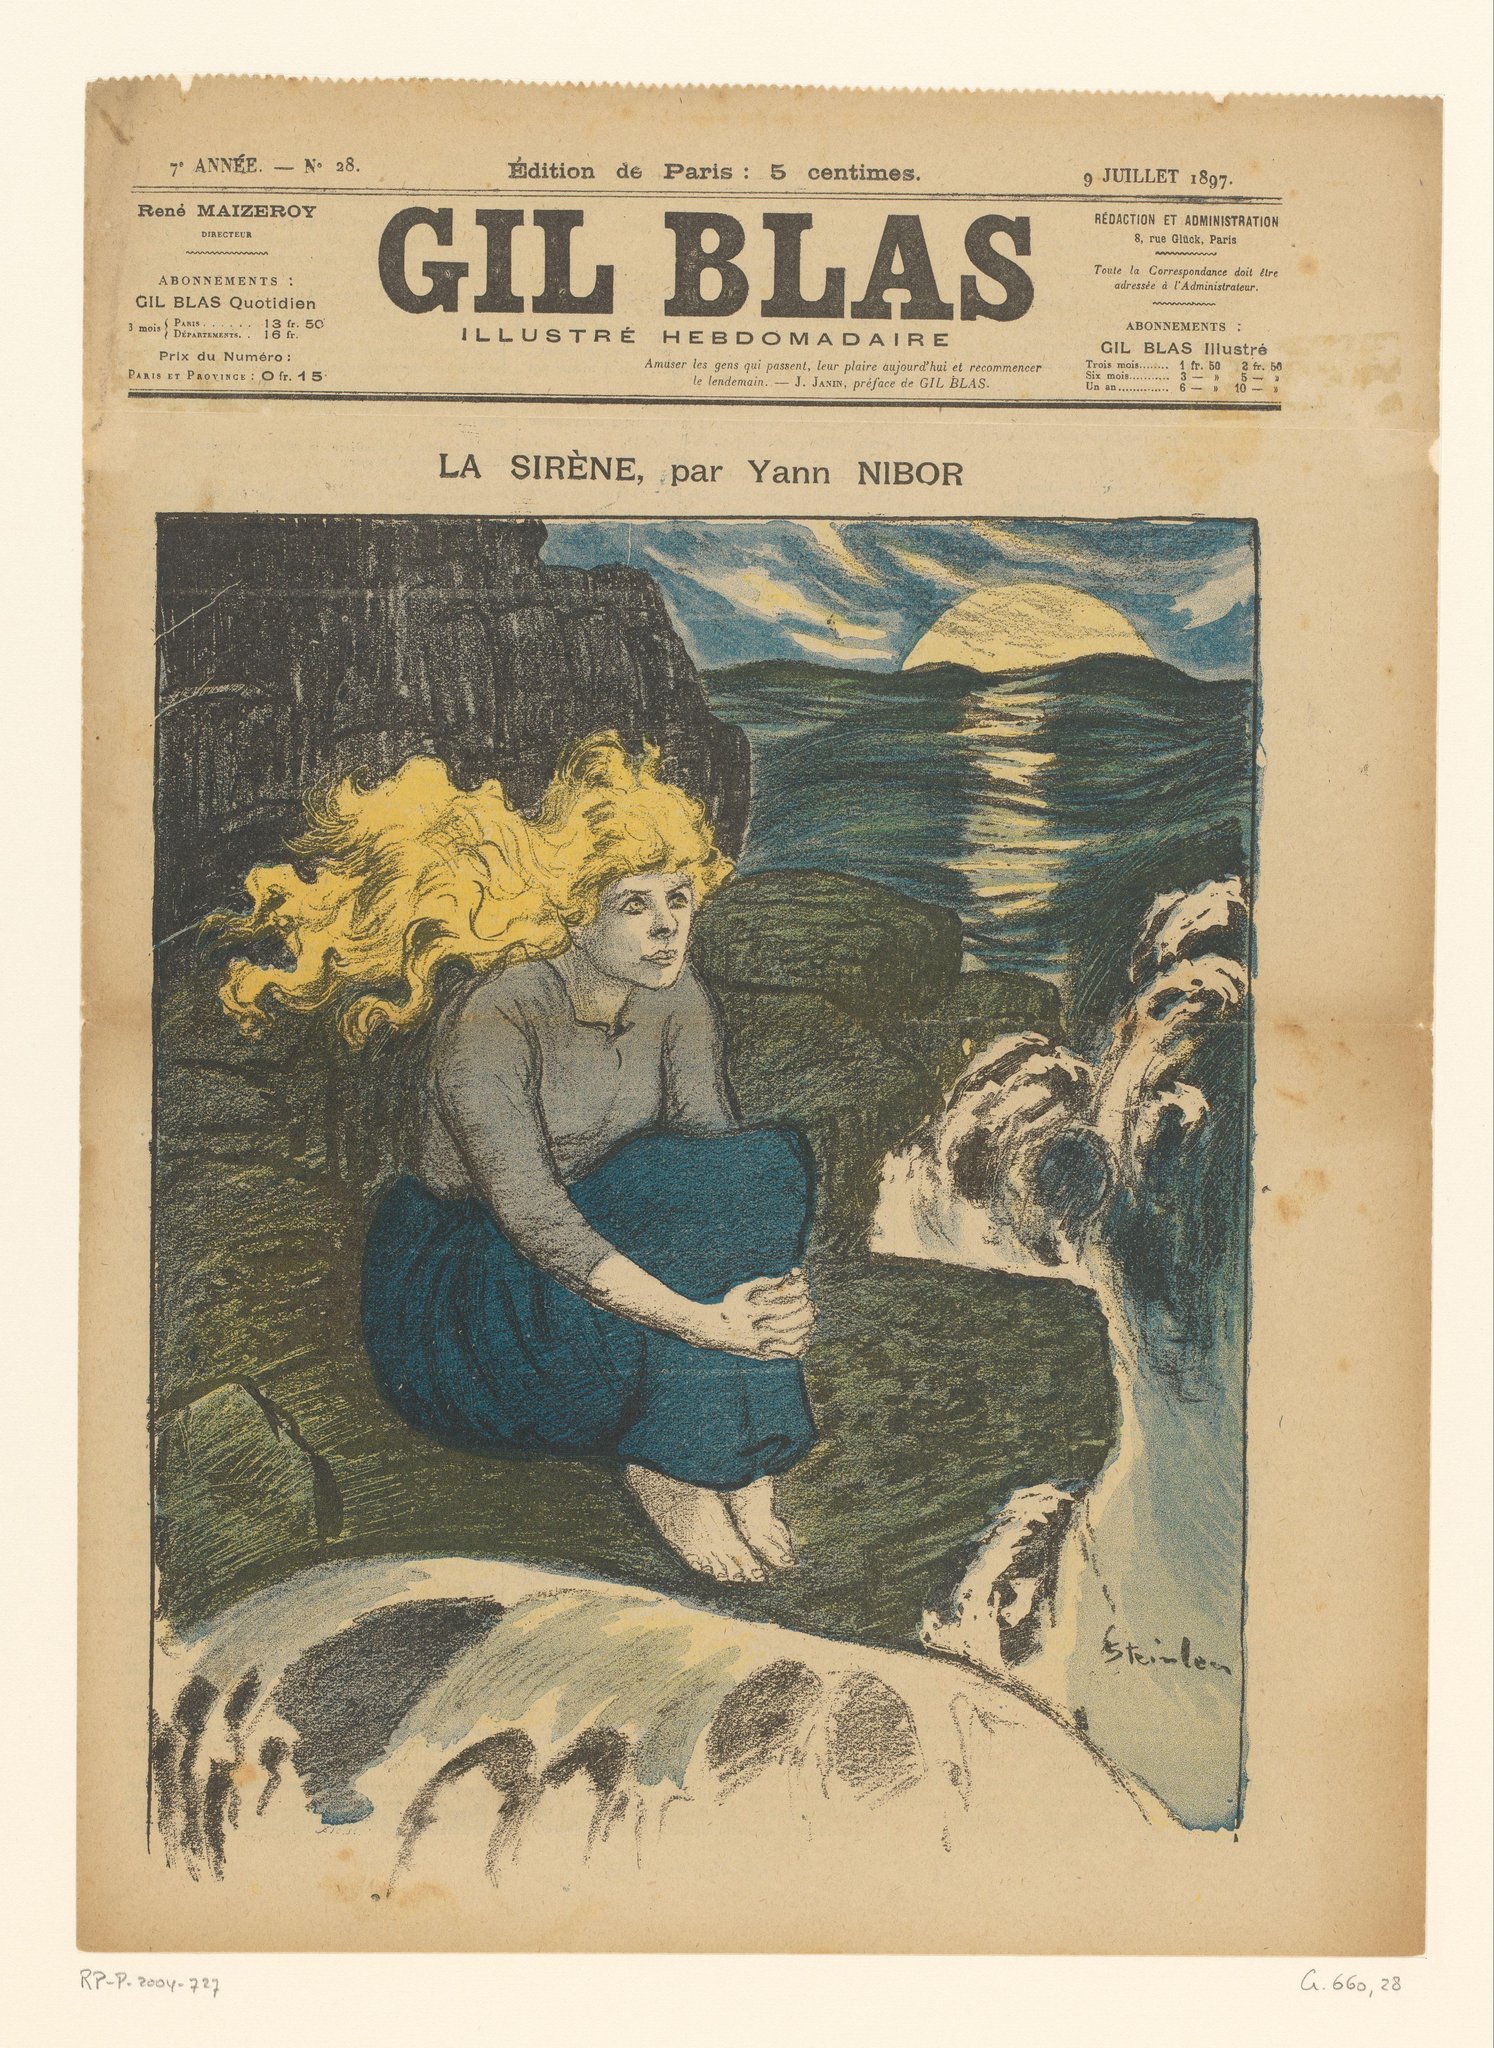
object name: print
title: La Sirène, par Yann Nibor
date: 1897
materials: paper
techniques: lithograph, letterpress printing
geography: paris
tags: adult woman, coastal cliff or crag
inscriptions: collector's mark: Lugt 2228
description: Prent uit: Gil Blas 7 (1897), nr. 28, 9 juli 1897.